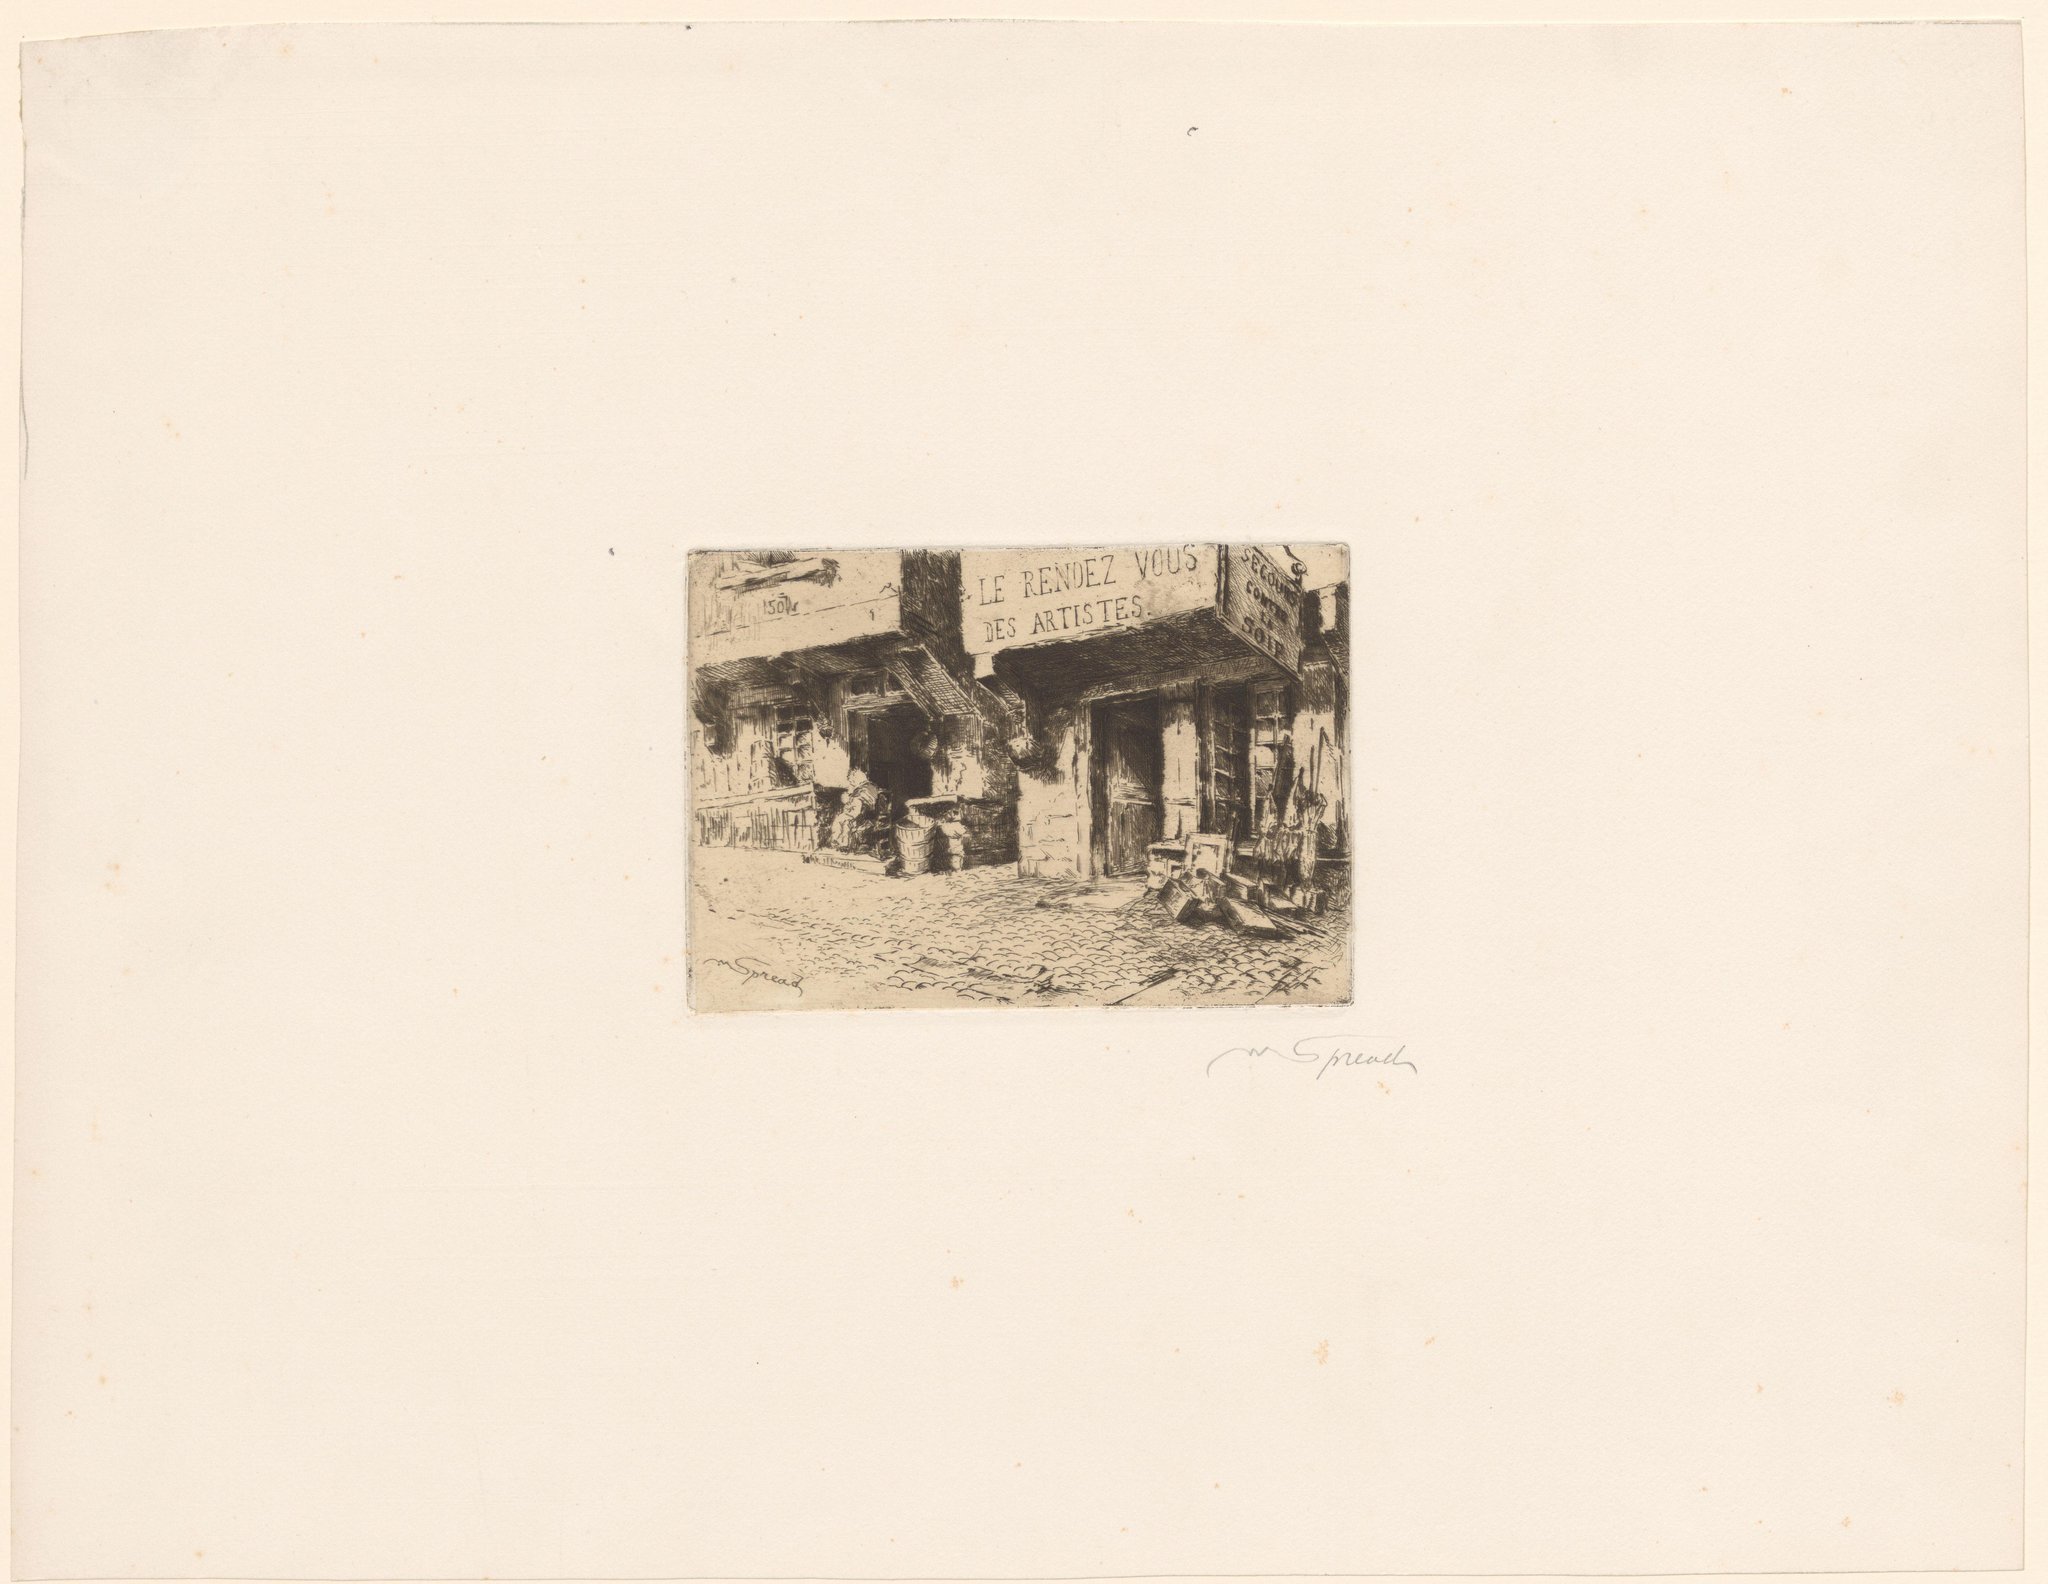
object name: print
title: Straat met een winkel 'Le rendez vous des Artistes'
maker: william spread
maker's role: print maker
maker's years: 1846-1909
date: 1856-1909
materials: paper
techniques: etching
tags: shop, store, street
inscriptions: collector's mark: Lugt 2228